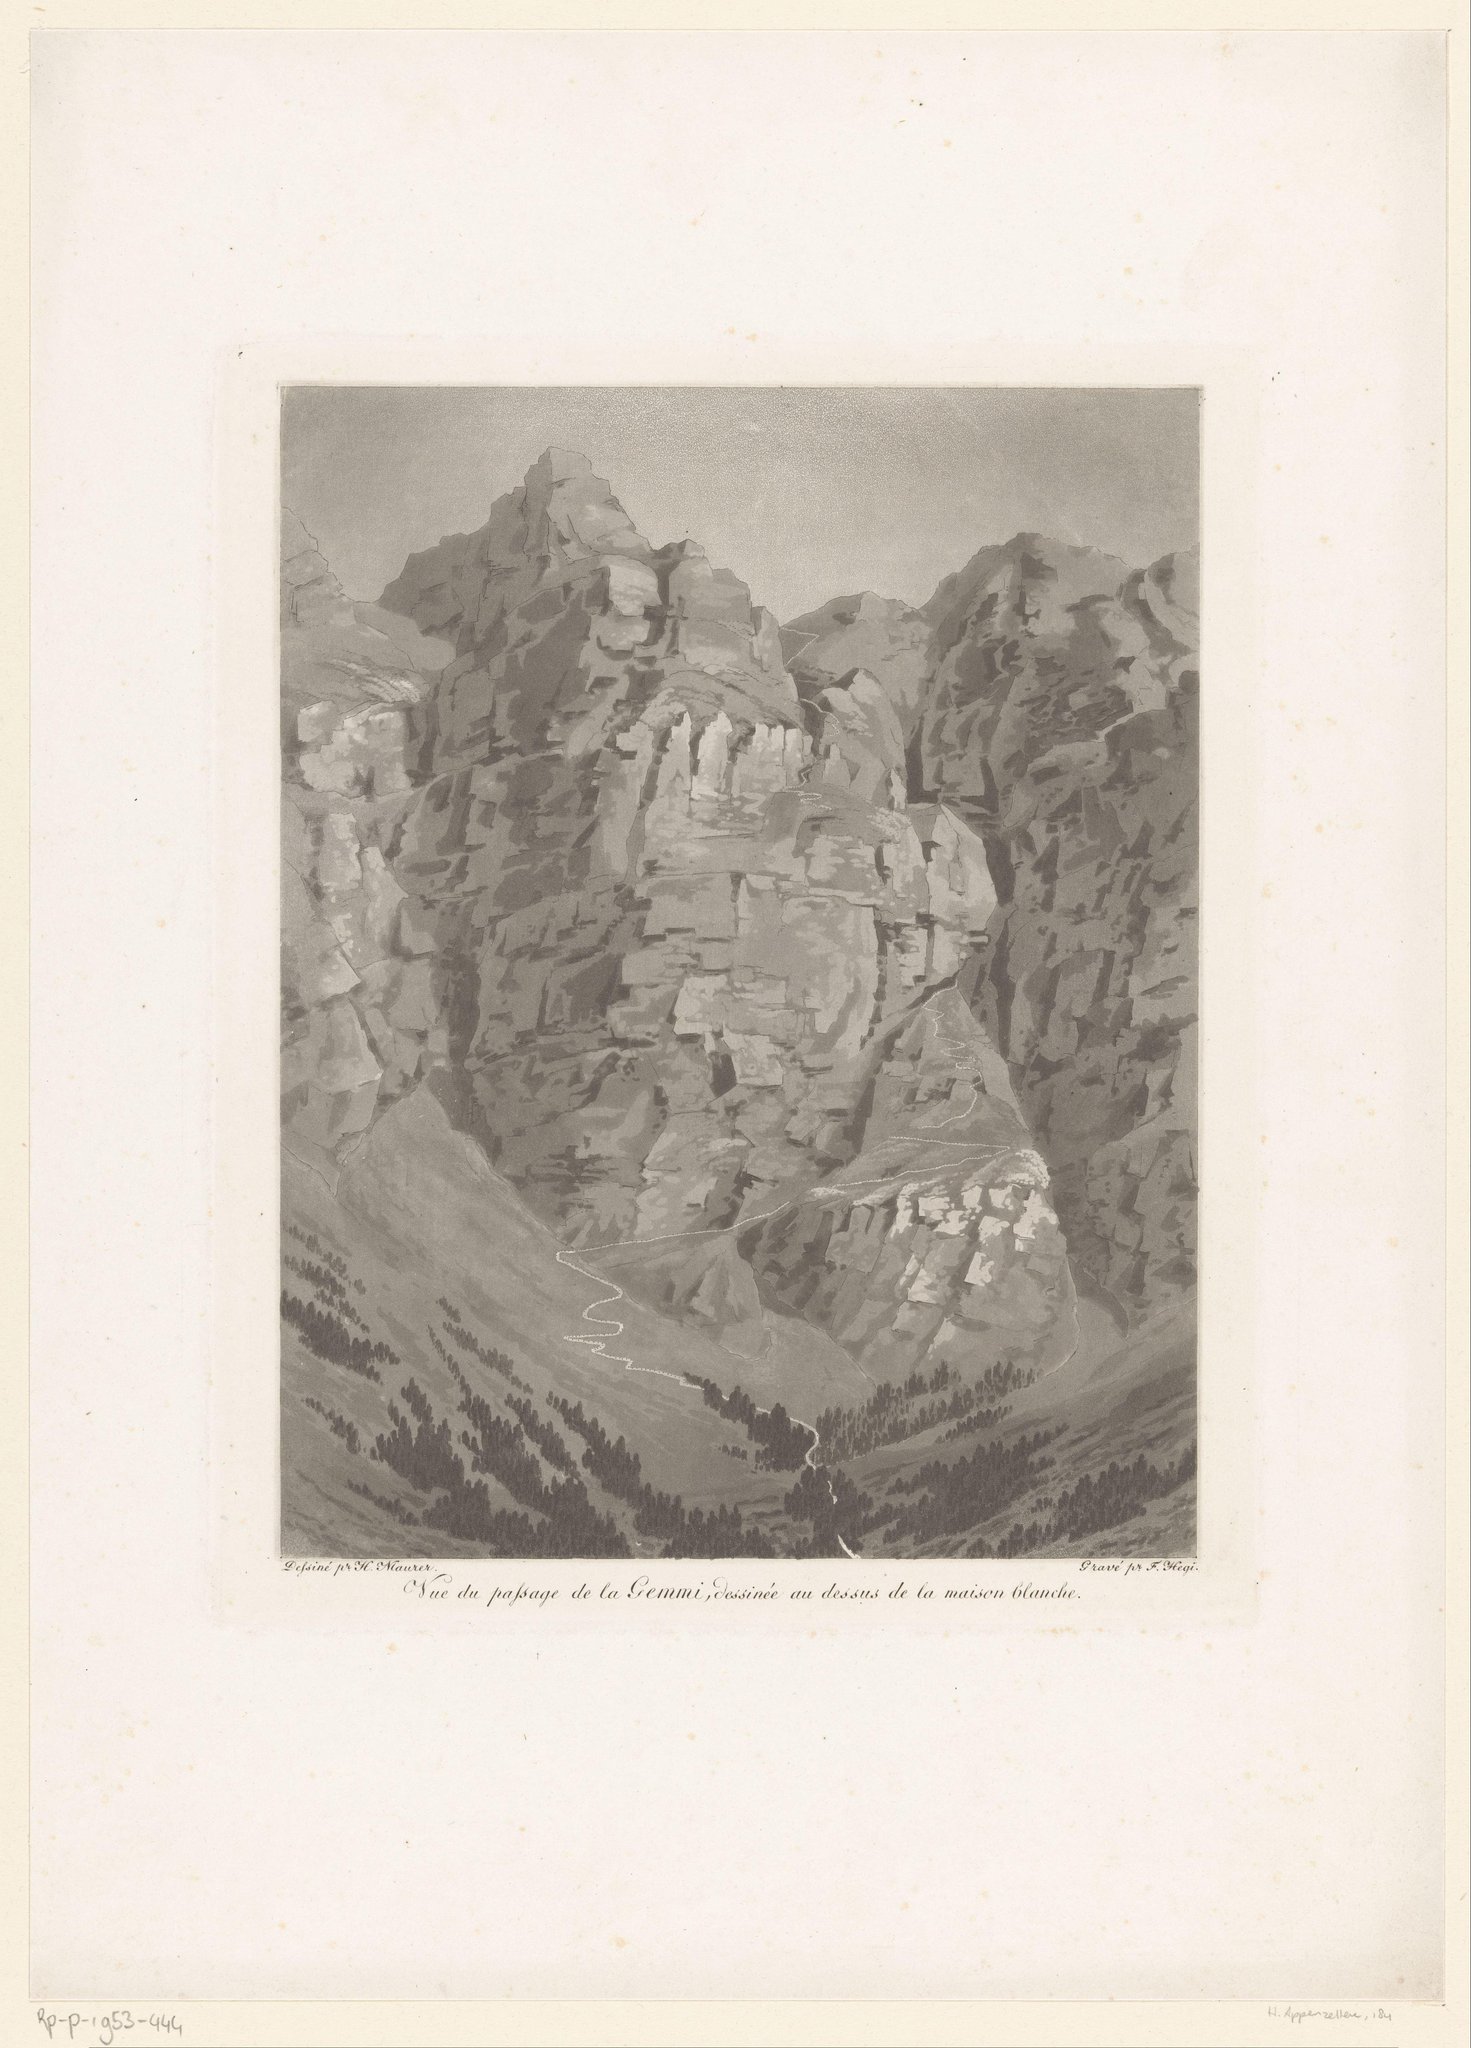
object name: print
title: Vue du passage de la Gemmi, dessineé de la maison blanche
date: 1784-1850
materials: paper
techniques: aquatint, etching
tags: rock-formations, passage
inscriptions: collector's mark: Lugt 2760, collector's mark: Lugt 2228